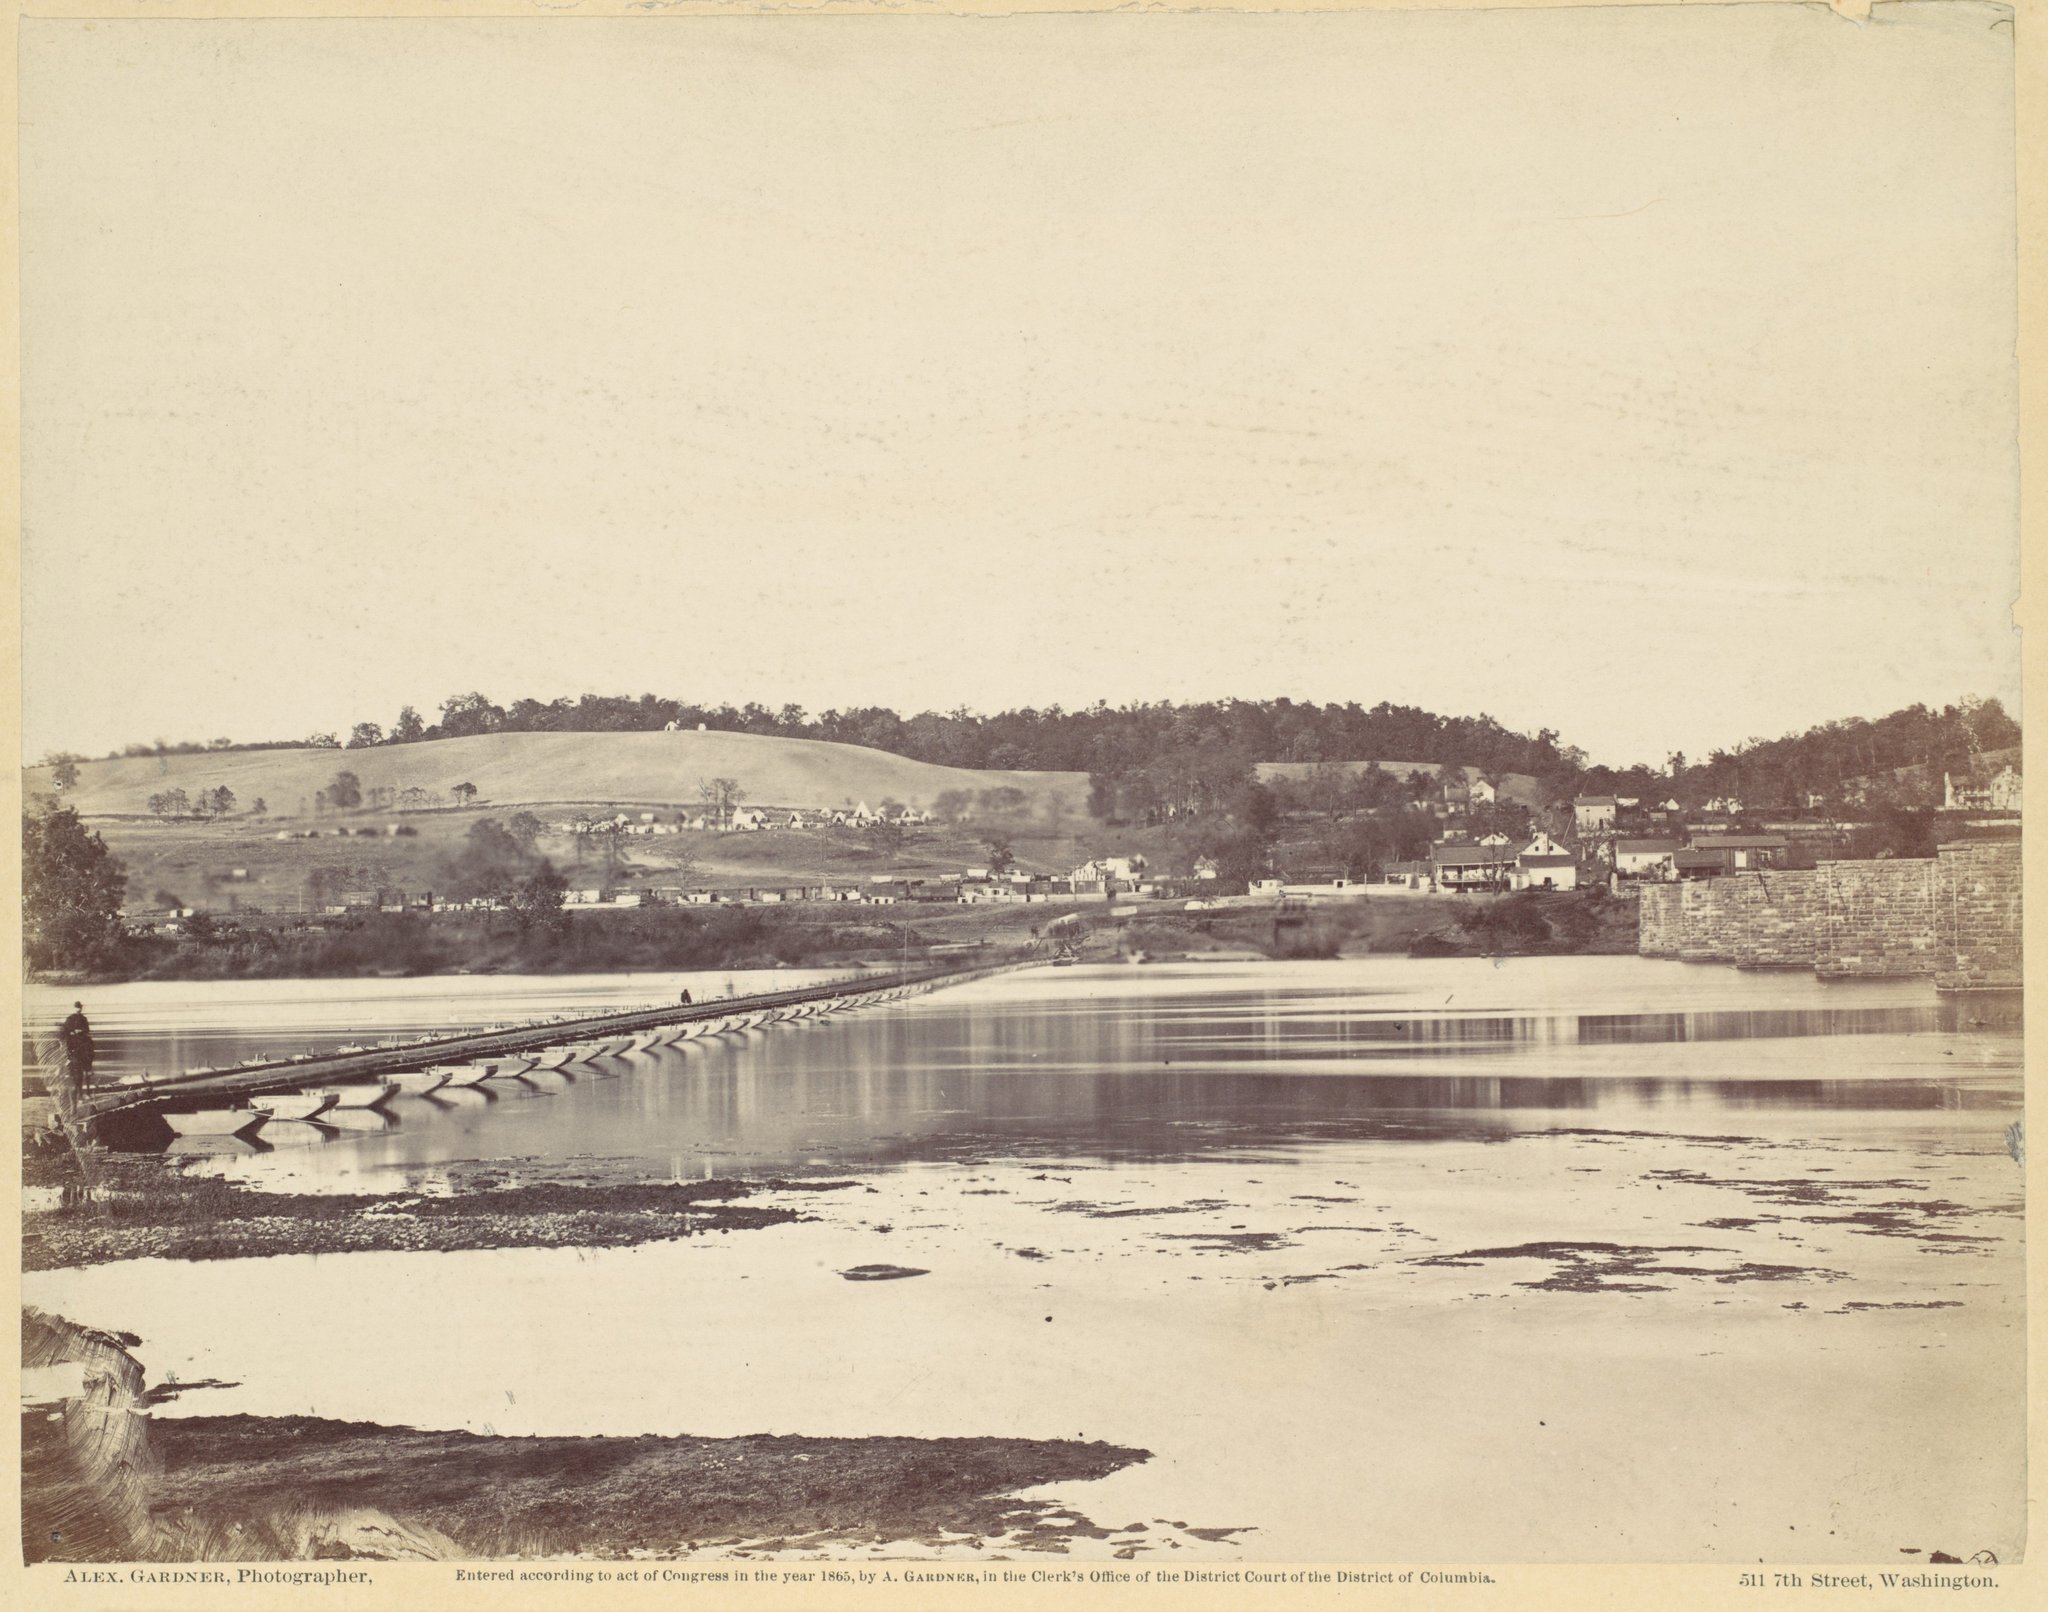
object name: photograph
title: Pontoon Bridge, Across the Potomac, at Berlin, Maryland, November 1862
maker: alexander gardner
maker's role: artist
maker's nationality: american, scottish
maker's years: 1821-1882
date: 1862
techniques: albumen silver print, glass negative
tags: bridges,american civil war,landscapes